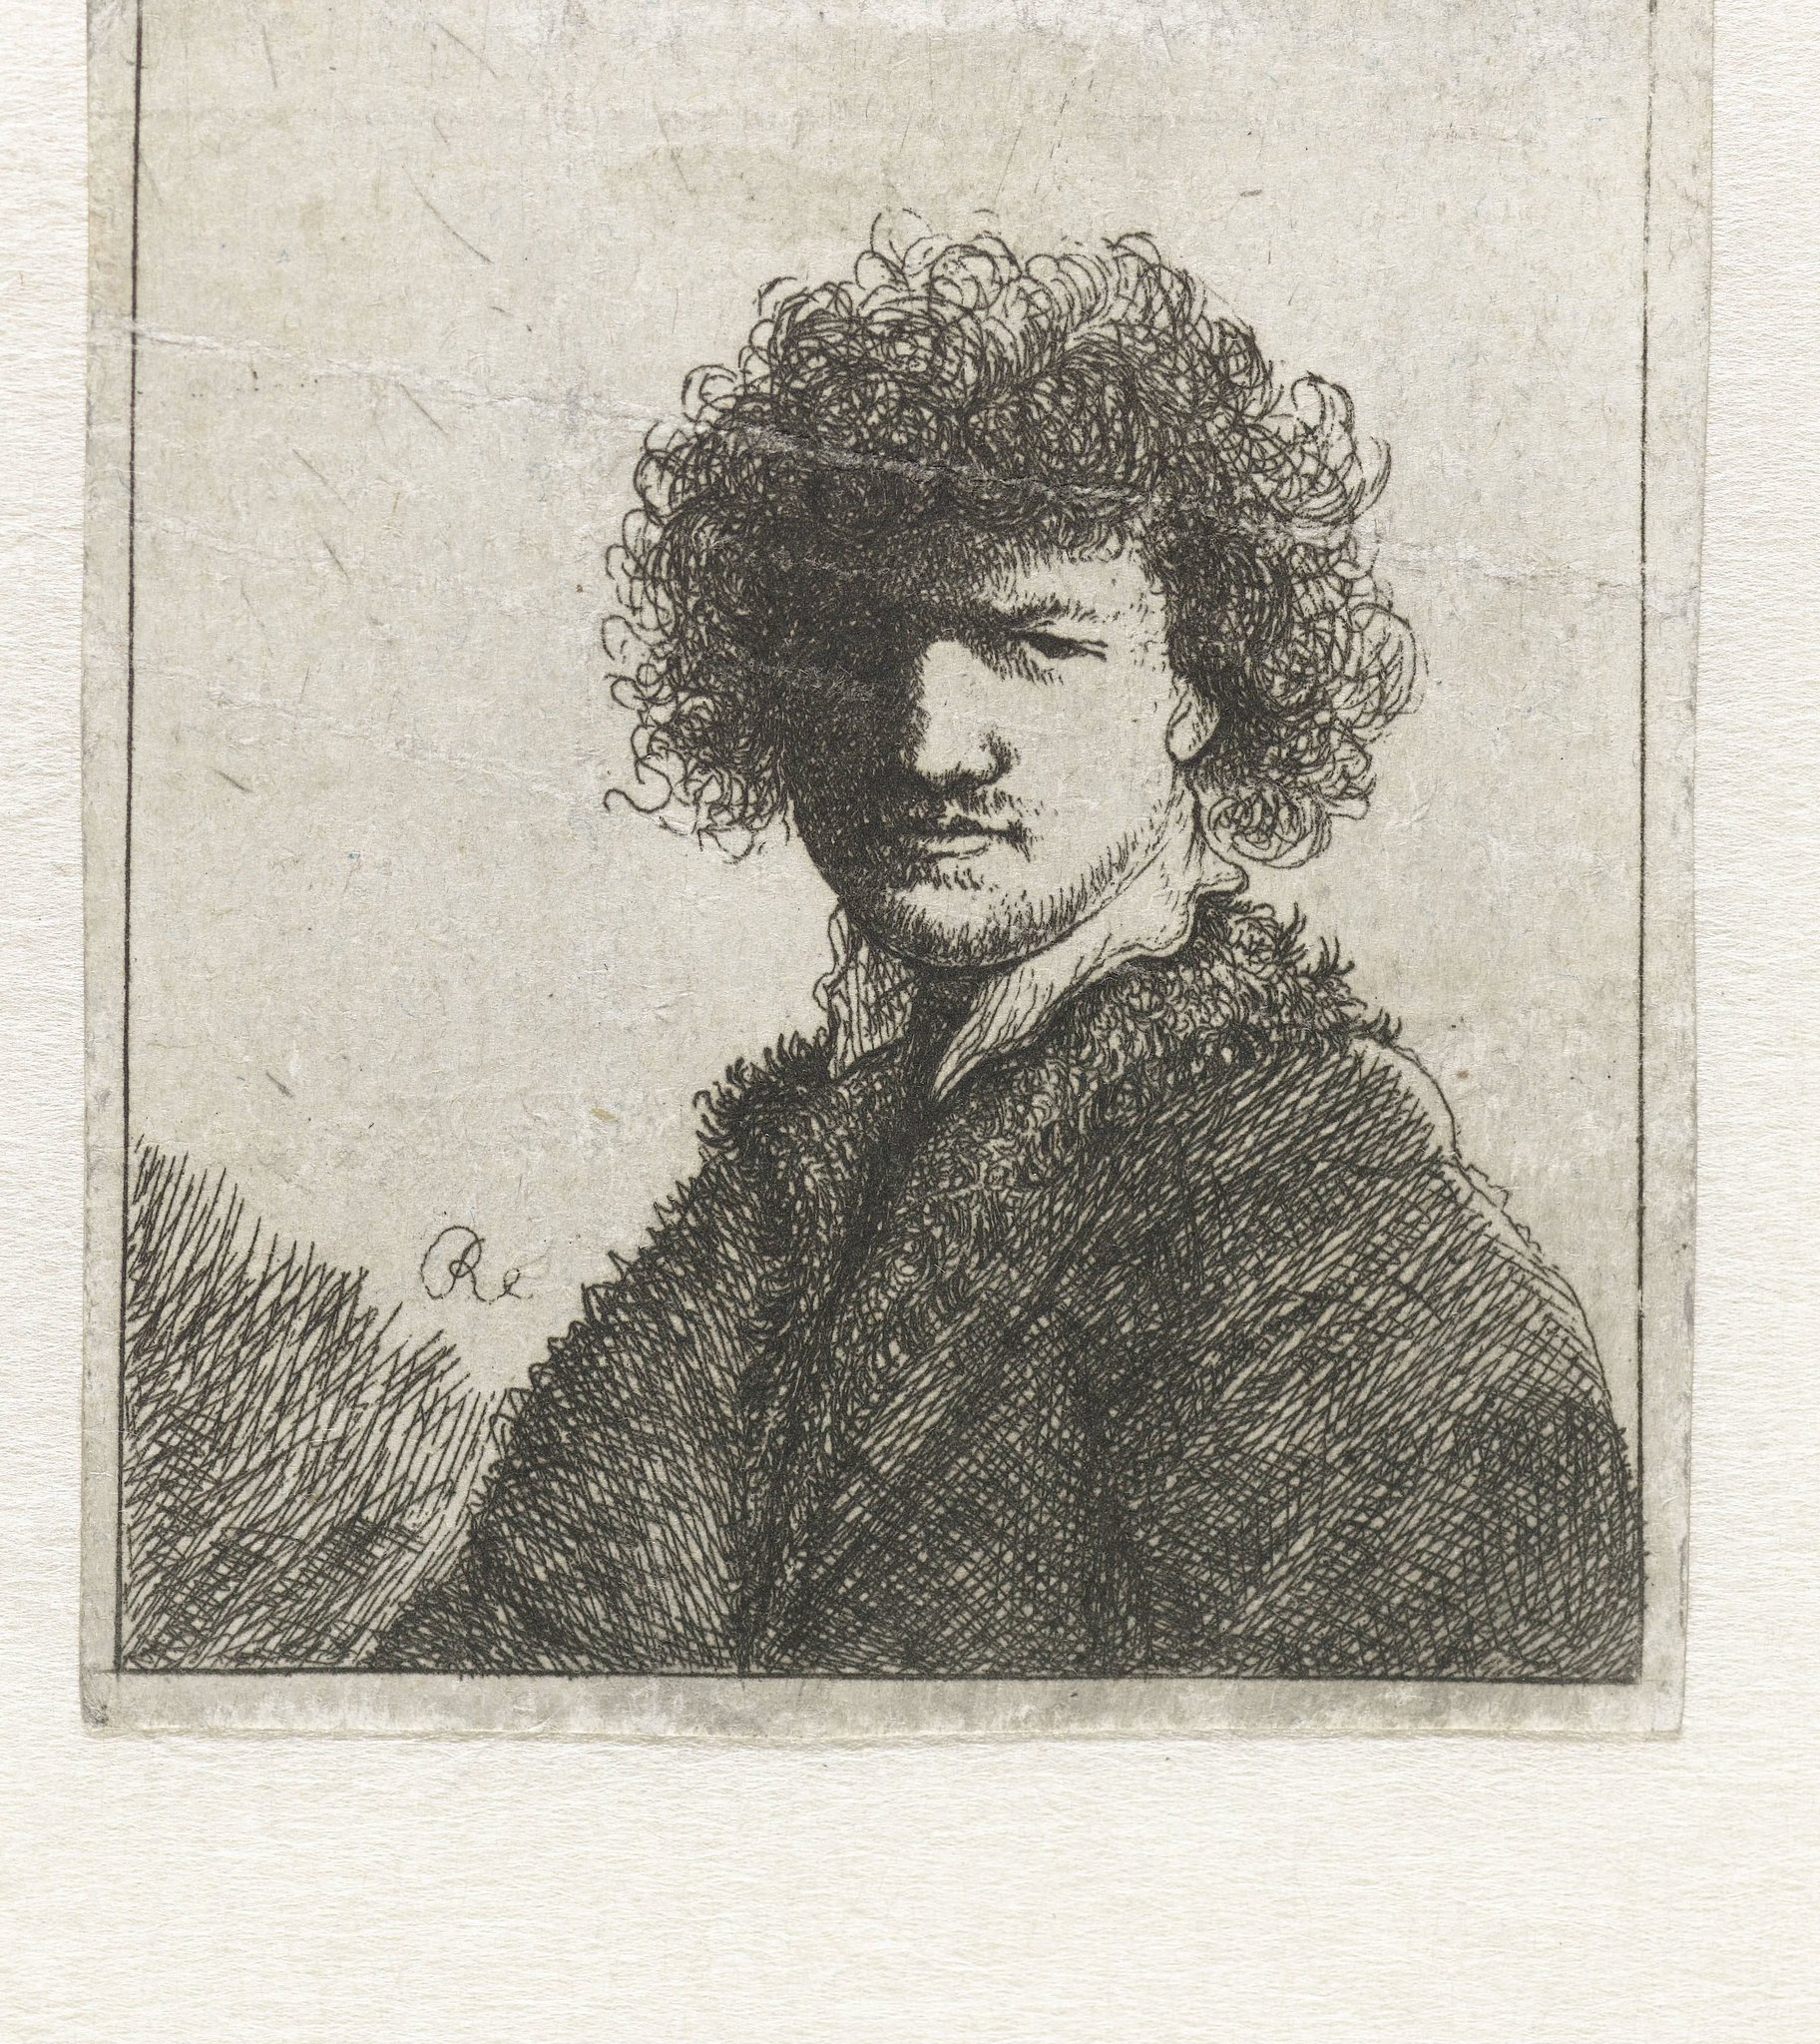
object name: print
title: Self-portrait with curly hair and white collar: bust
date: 1753-1808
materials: paper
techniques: etching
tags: leiden, amsterdam, print maker, draughtsman, rembrandt van rijn, portrait, self-portrait of graphic artist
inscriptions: collector's mark: Lugt 2760, collector's mark: ‘68’, collector's mark: Lugt 2228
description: Spiegelbeeldige kopie naar de gelijknamige prent van Rembrandt.